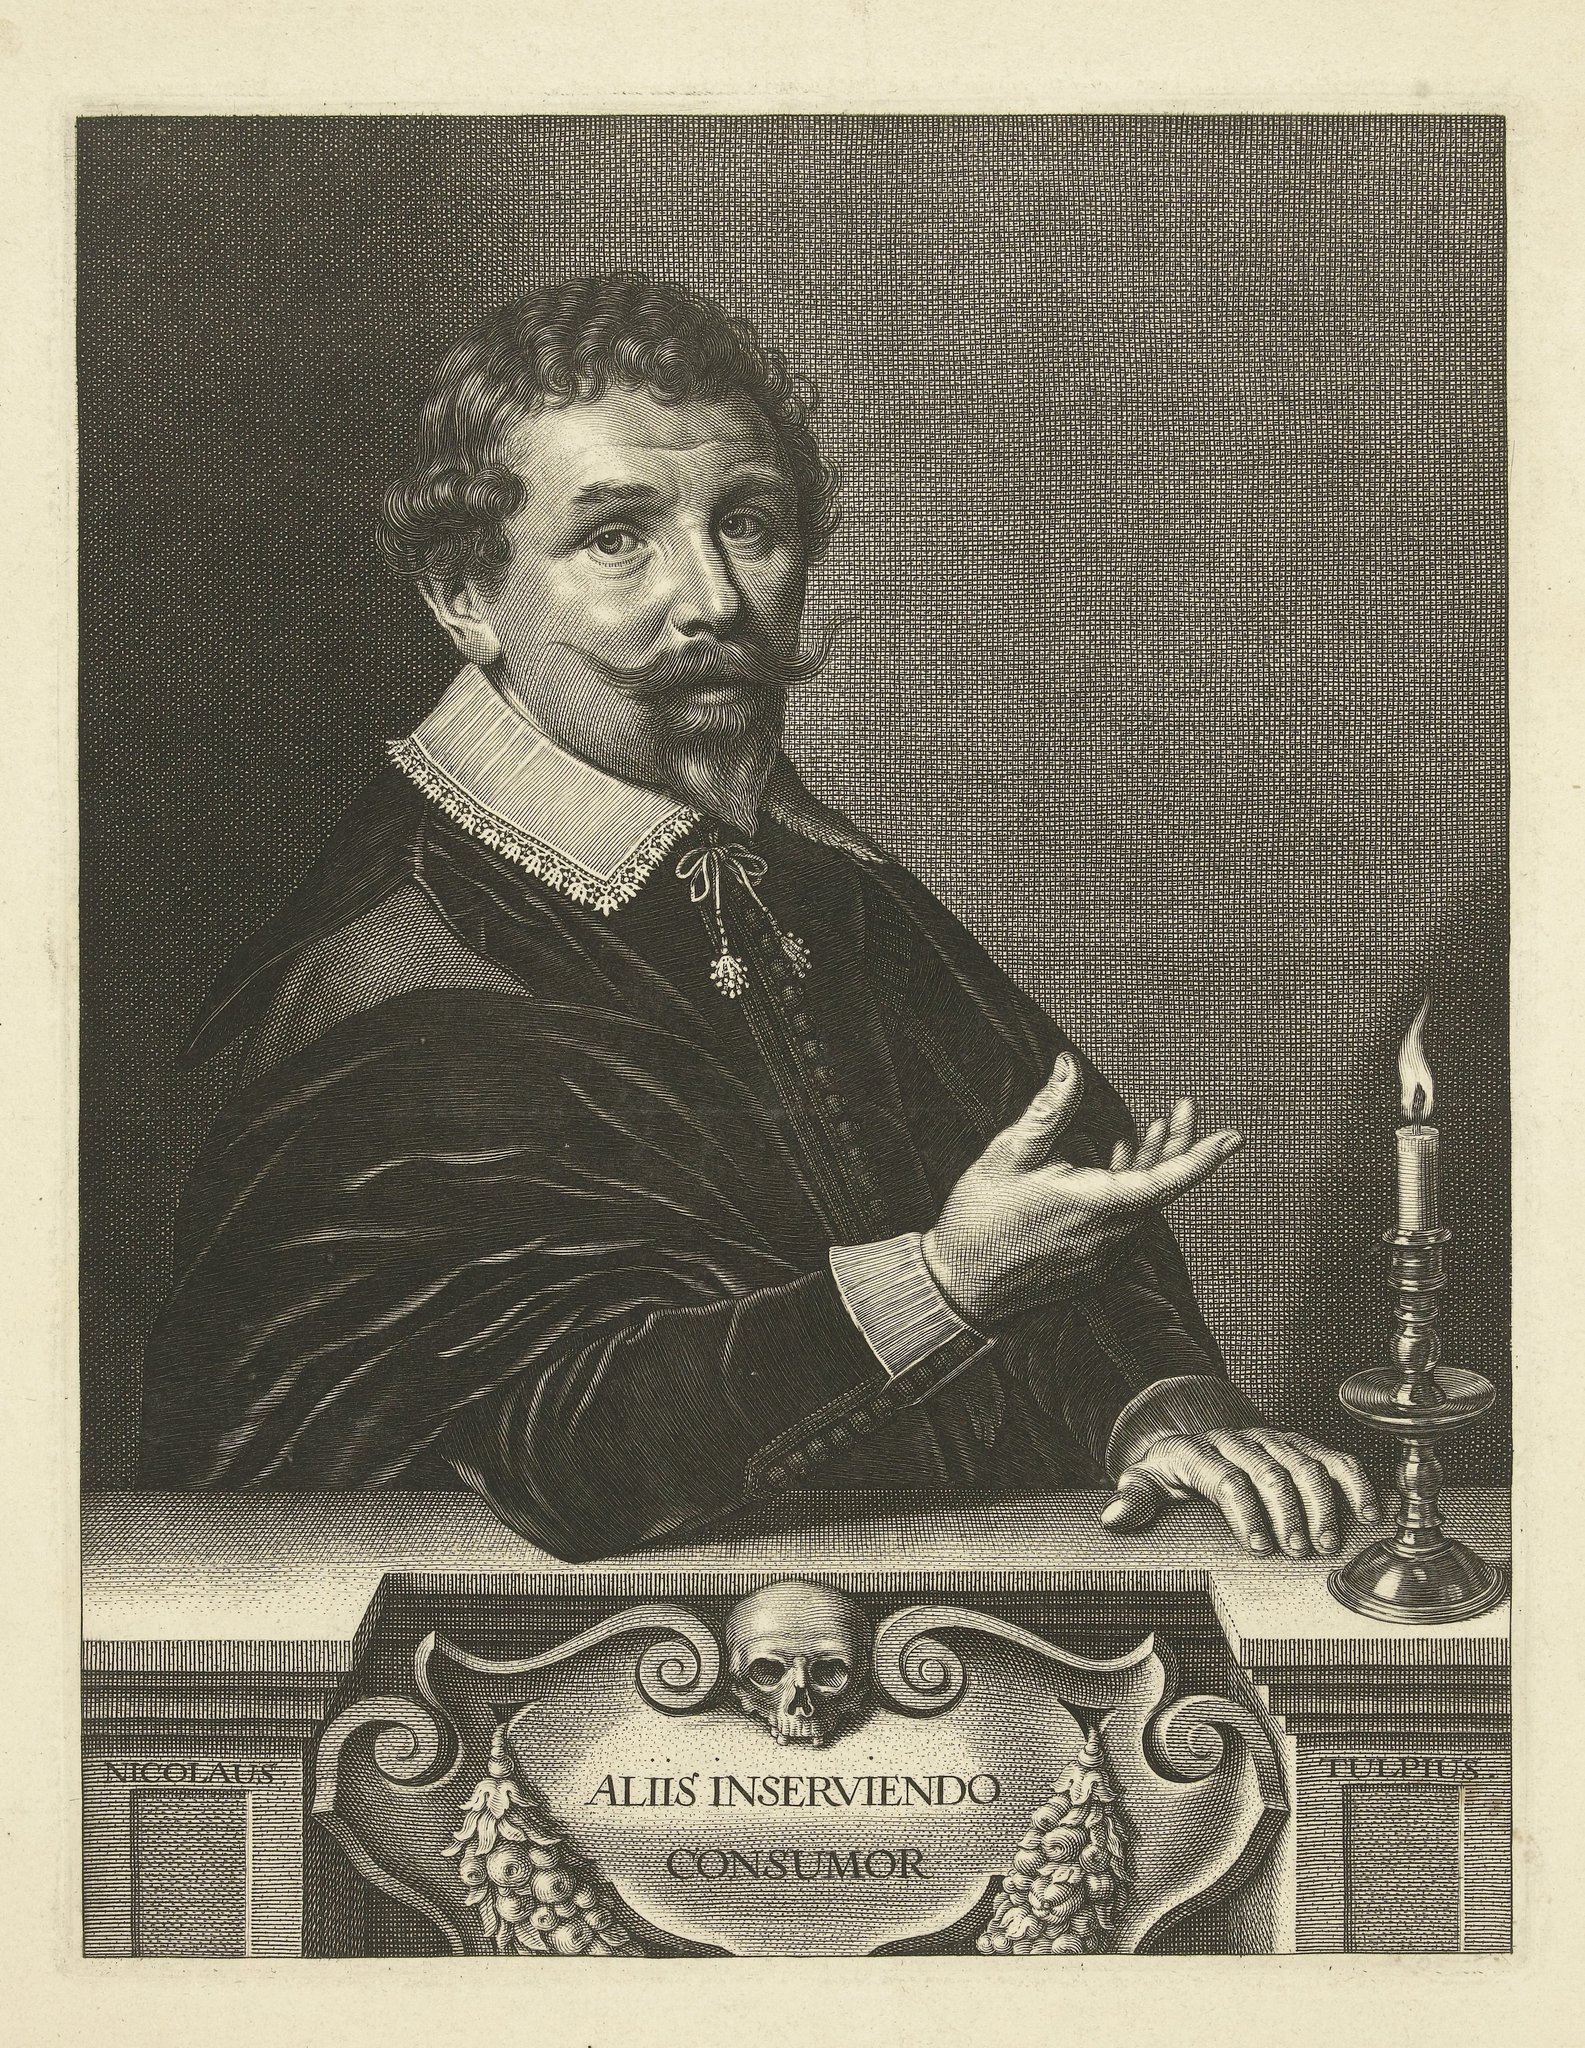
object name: print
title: Portret van Nicolaas Tulp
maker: cornelis van dalen (i)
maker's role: print maker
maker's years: 1602-1665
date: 1612-1665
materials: paper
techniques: engraving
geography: amsterdam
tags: the hague, mayor, 'vanitas' symbols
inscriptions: collector's mark: Lugt 240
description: Portret van Nicolaas Tulp, ten halven lijve achter balustrade. Hij wijst met zijn vinger naar een kaars die opbrandt, een gebaar dat nog eens onderstreept wordt door het motto op een cartouche met schedel: Aliis inserviendo consumor.